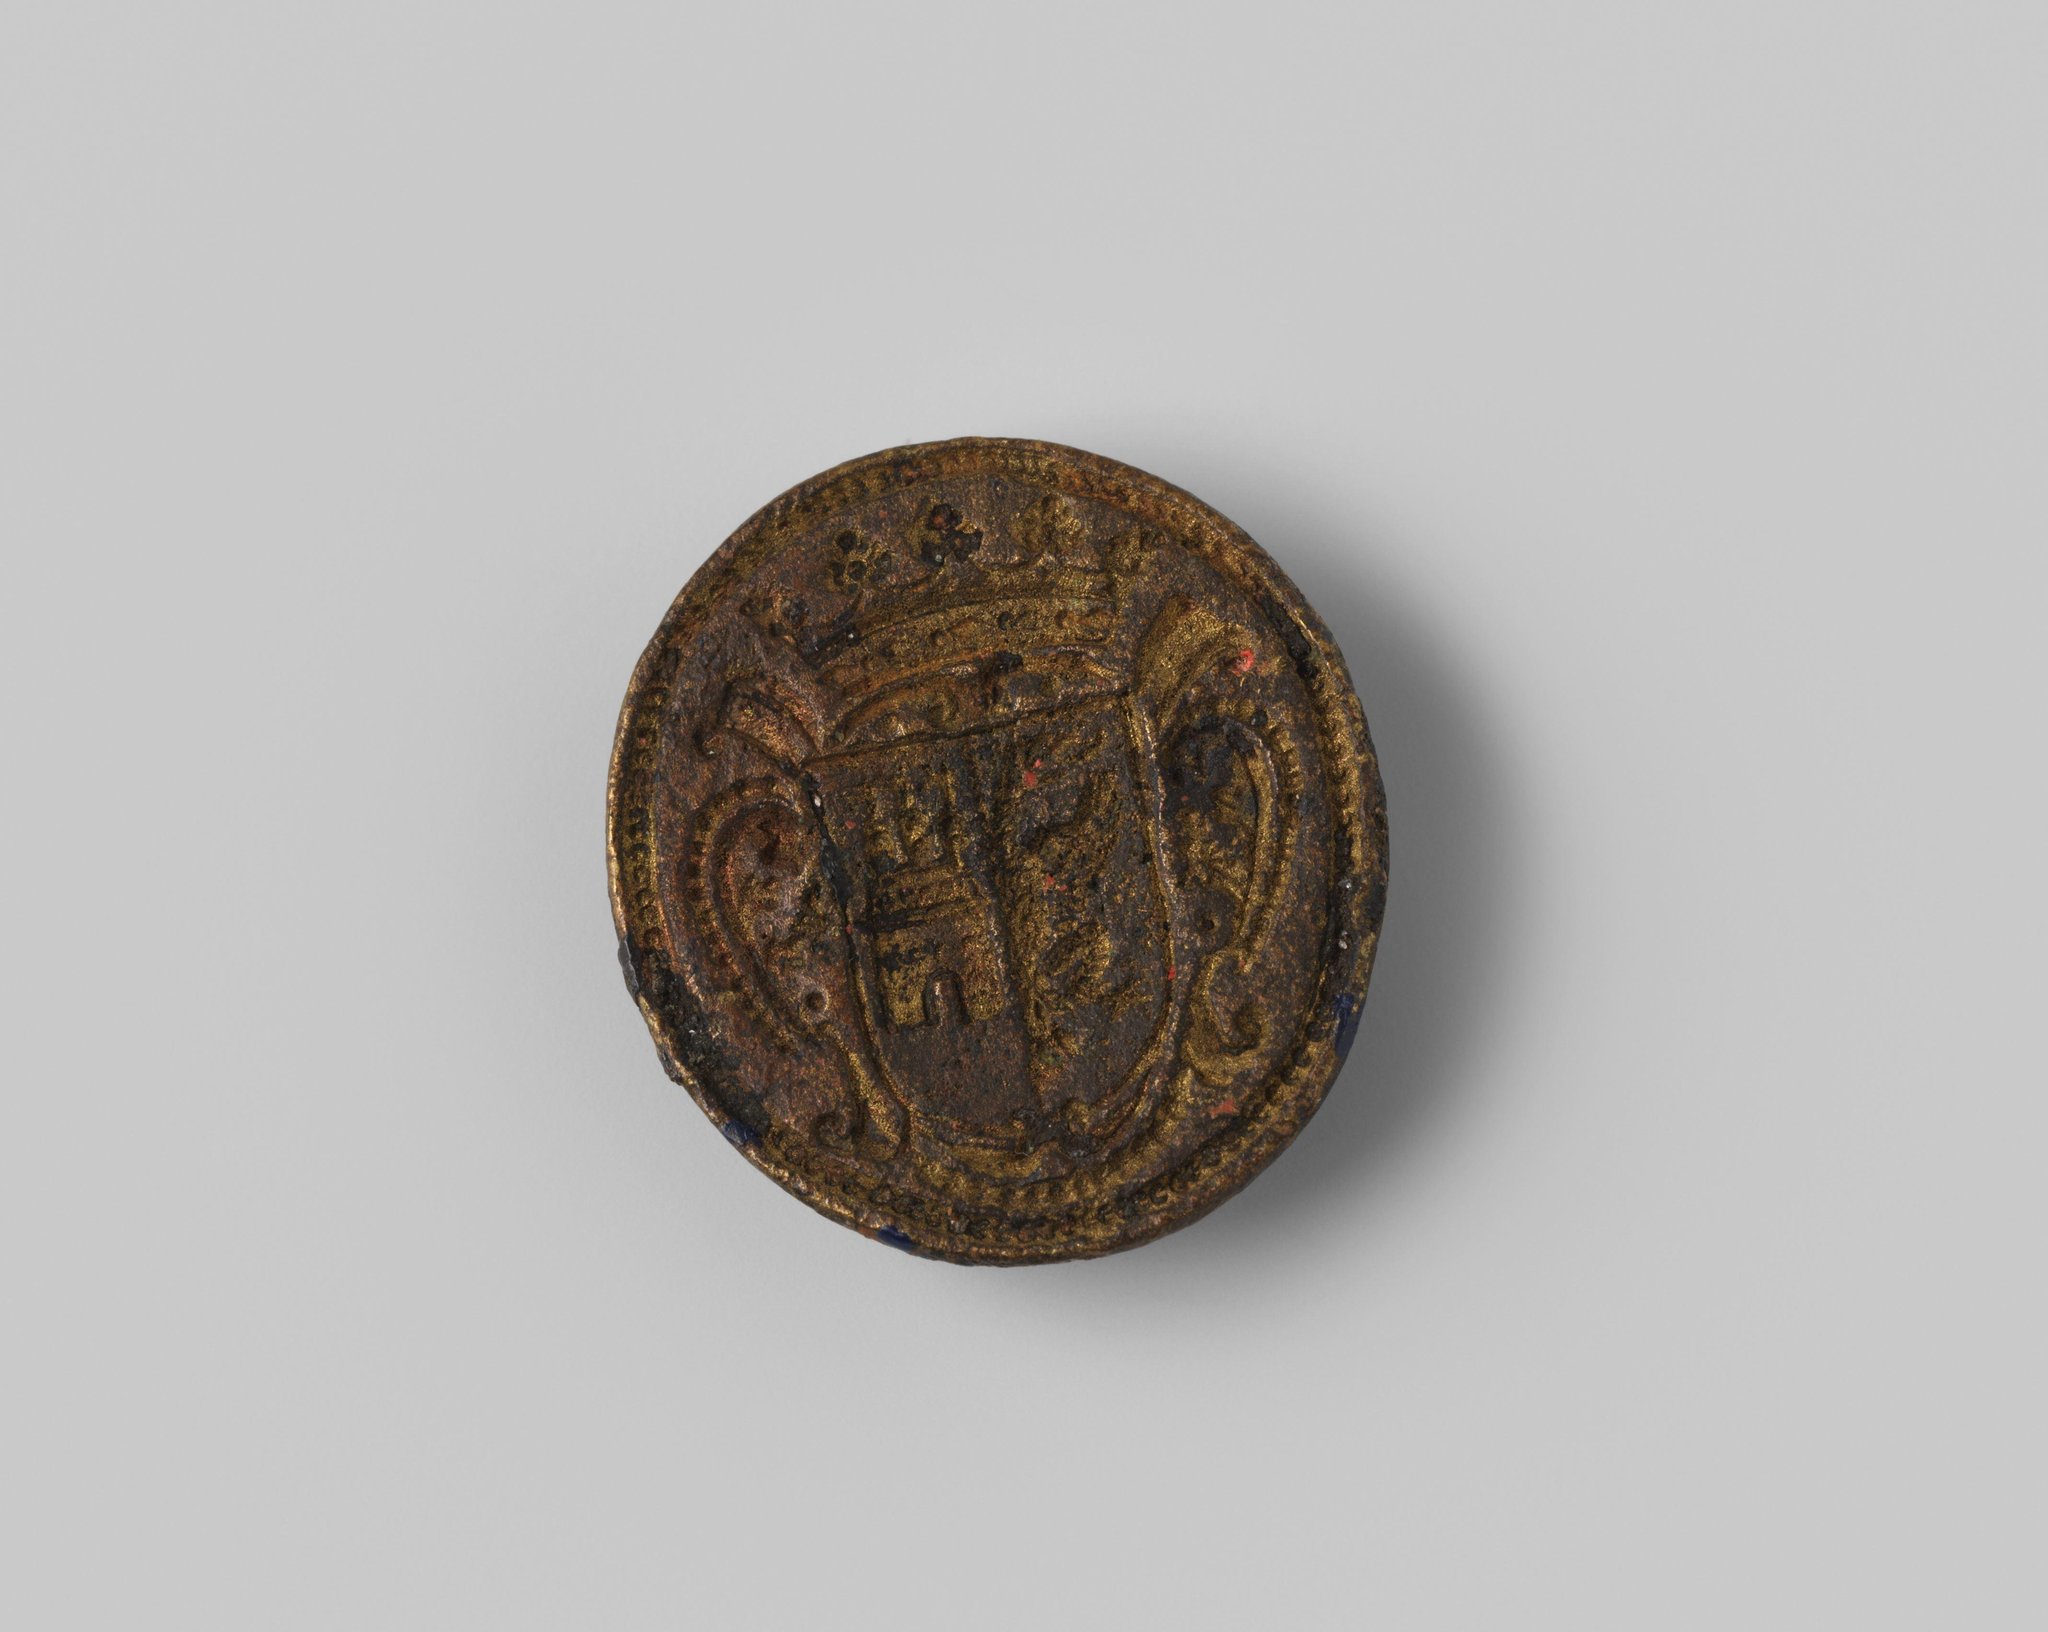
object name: signet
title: Cachet seal of Pompejus Gruijs from the wreck of the Dutch East Indiaman Hollandia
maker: Anonymous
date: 1700-1743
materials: copper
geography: netherlands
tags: verenigde oostindische compagnie, hollandia (schip), annet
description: Onderstuk van een signet met het familiewapen Pompejus Gruys (geb. te Groningen 3 juni 1722; gestorven met de Hollandia).